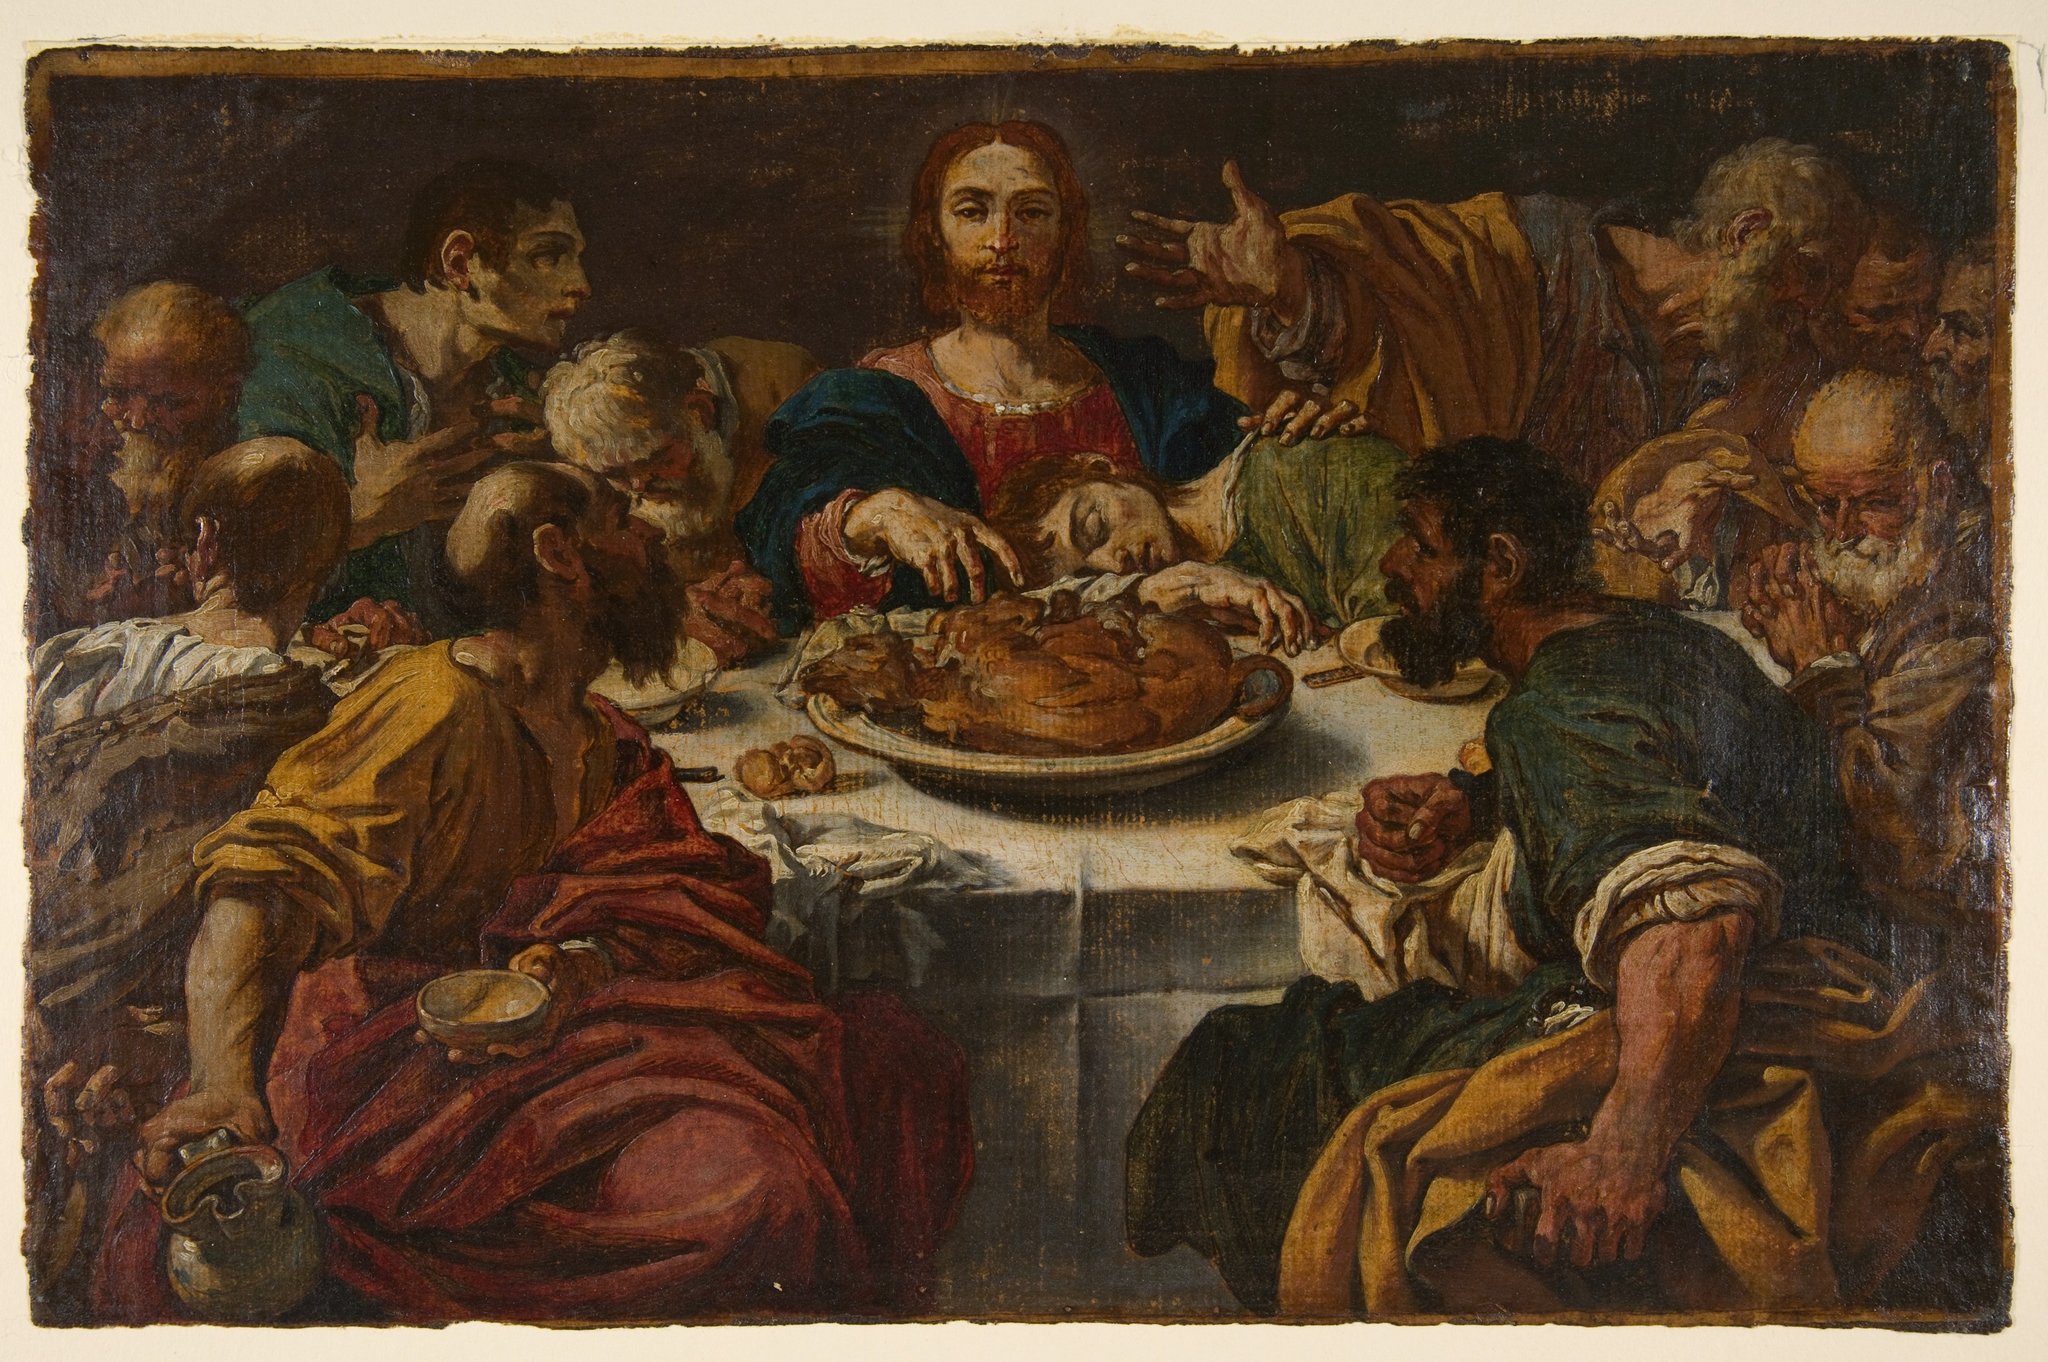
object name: drawing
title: The Last Supper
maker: bartolomeo schedoni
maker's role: artist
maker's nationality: italian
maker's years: 1578-1615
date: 1578-1615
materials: canvas, oil, paper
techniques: brush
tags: food,jesus,last supper